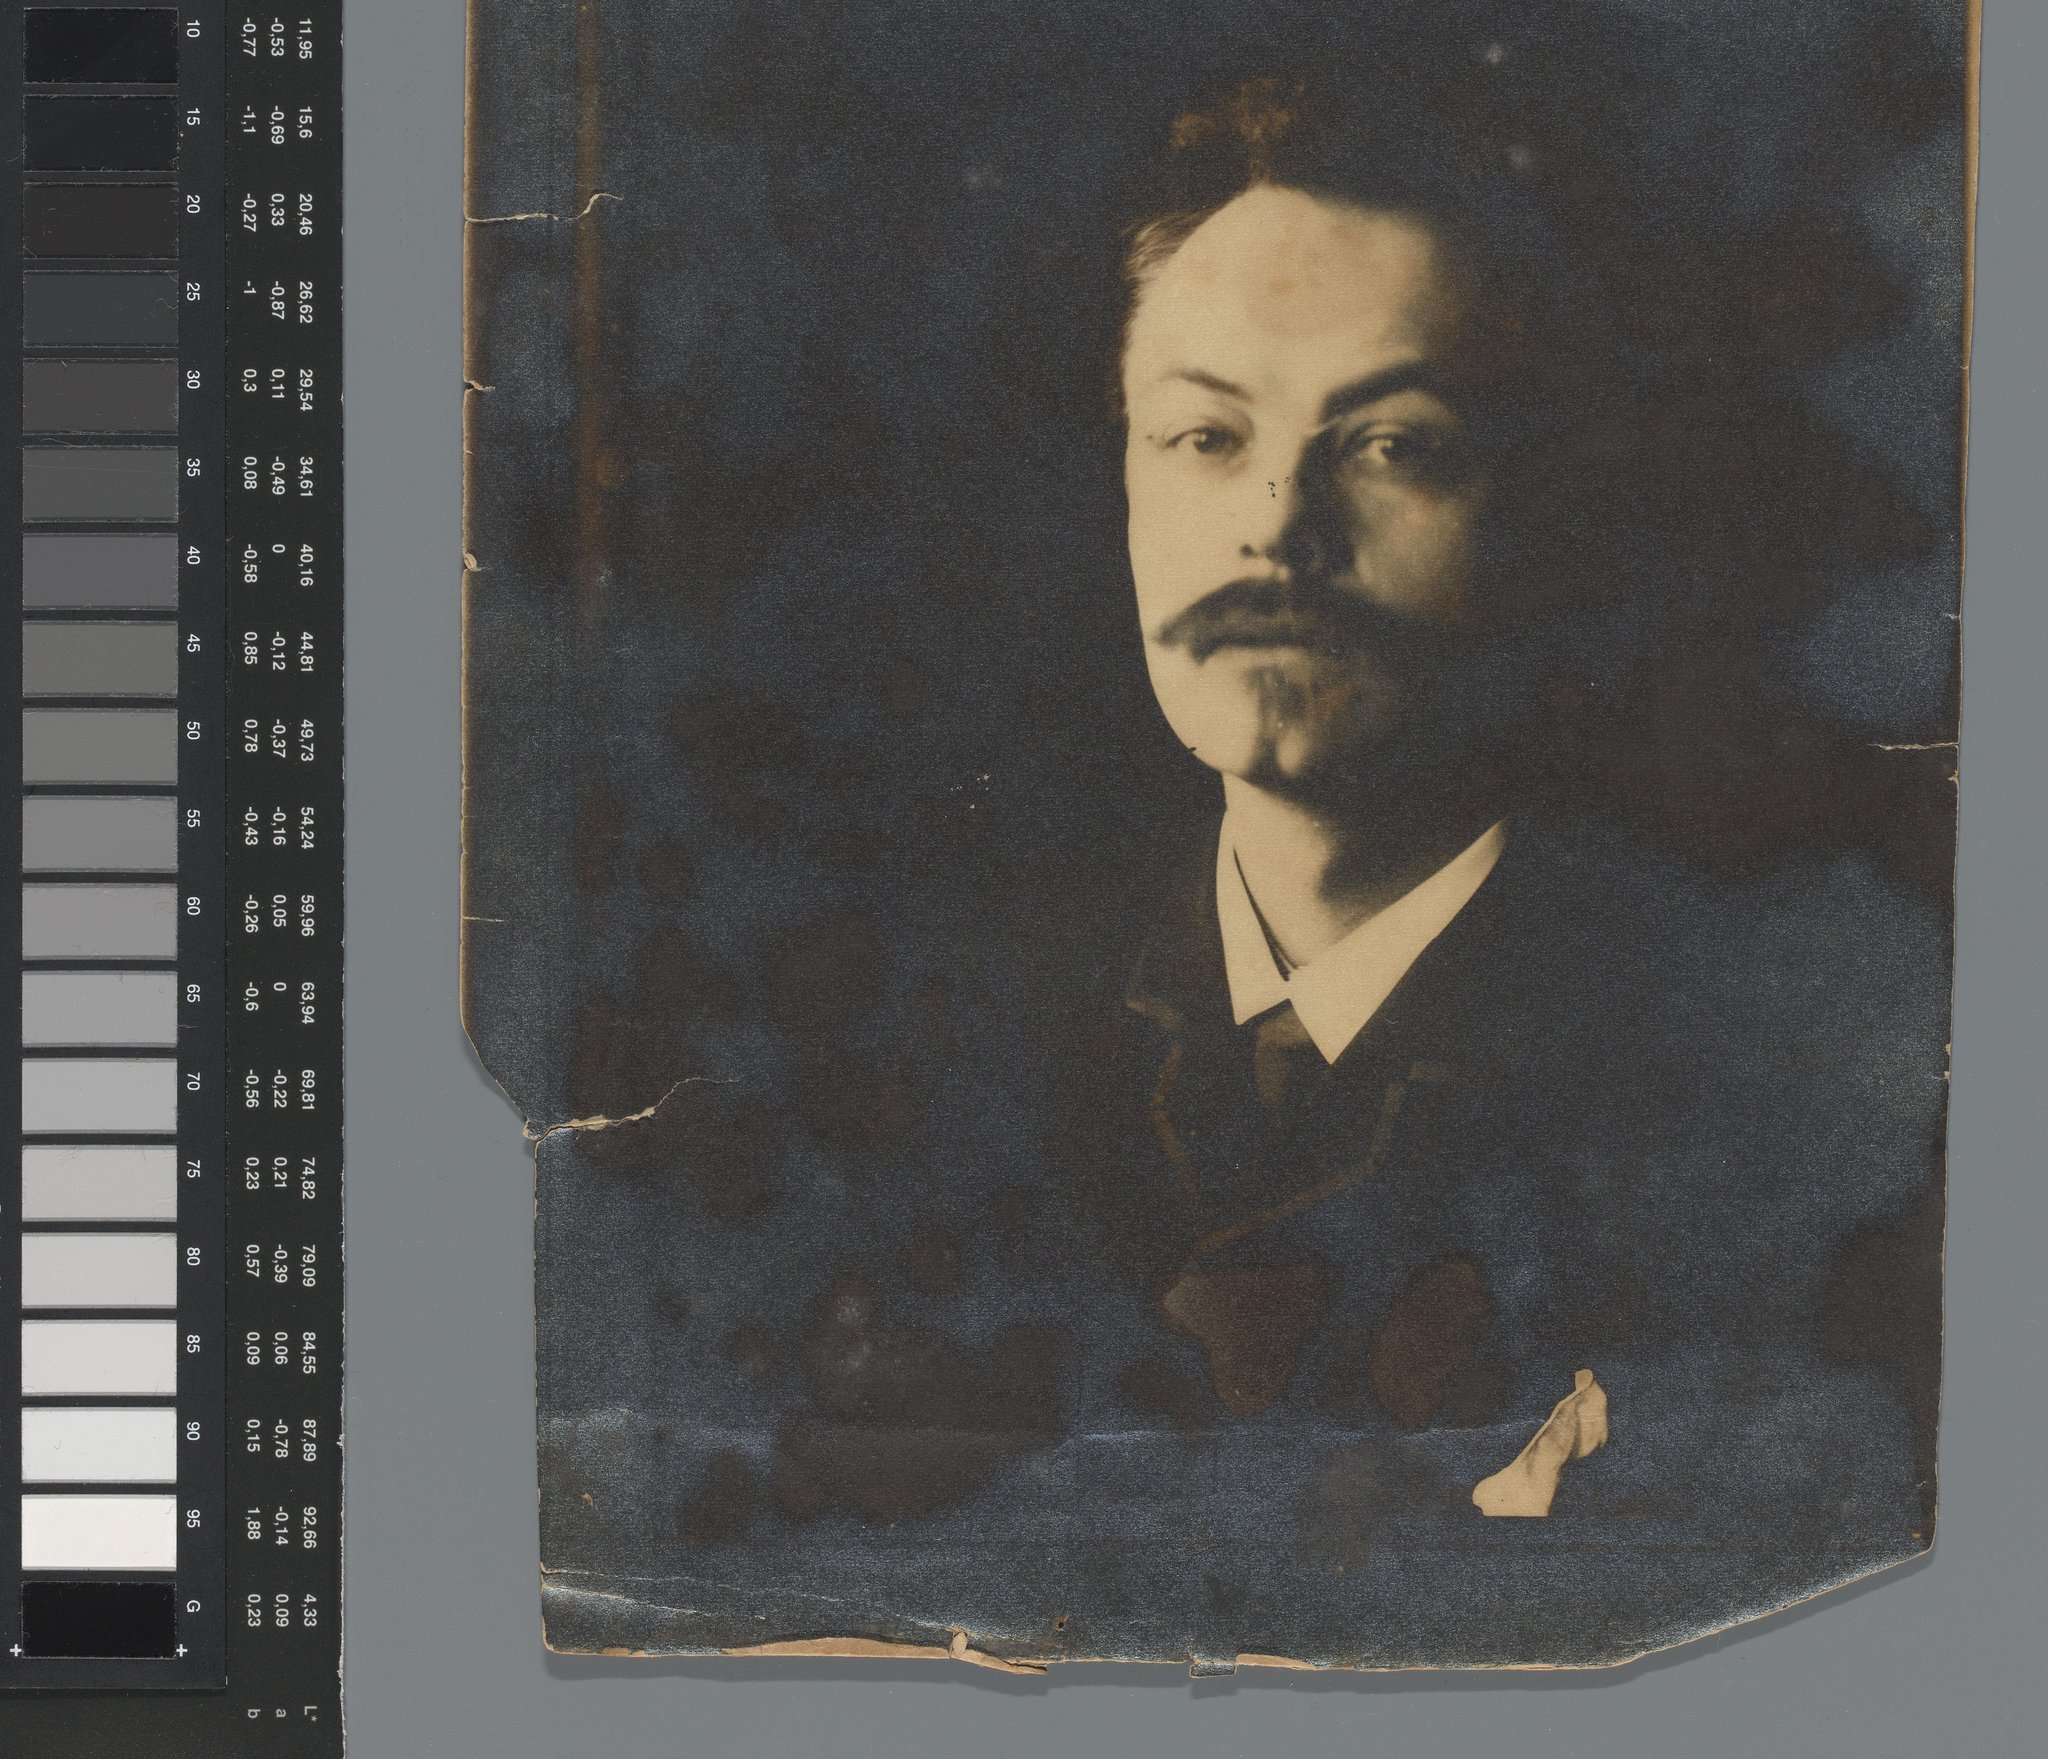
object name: photograph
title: Portret van Alphons Diepenbrock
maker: joseph jessurun de mesquita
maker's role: fotograaf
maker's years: 1865-1890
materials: photographic support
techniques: gelatin silver print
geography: netherlands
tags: alphons diepenbrock, portrait of composer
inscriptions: dedication: ‘Diepenbrock’